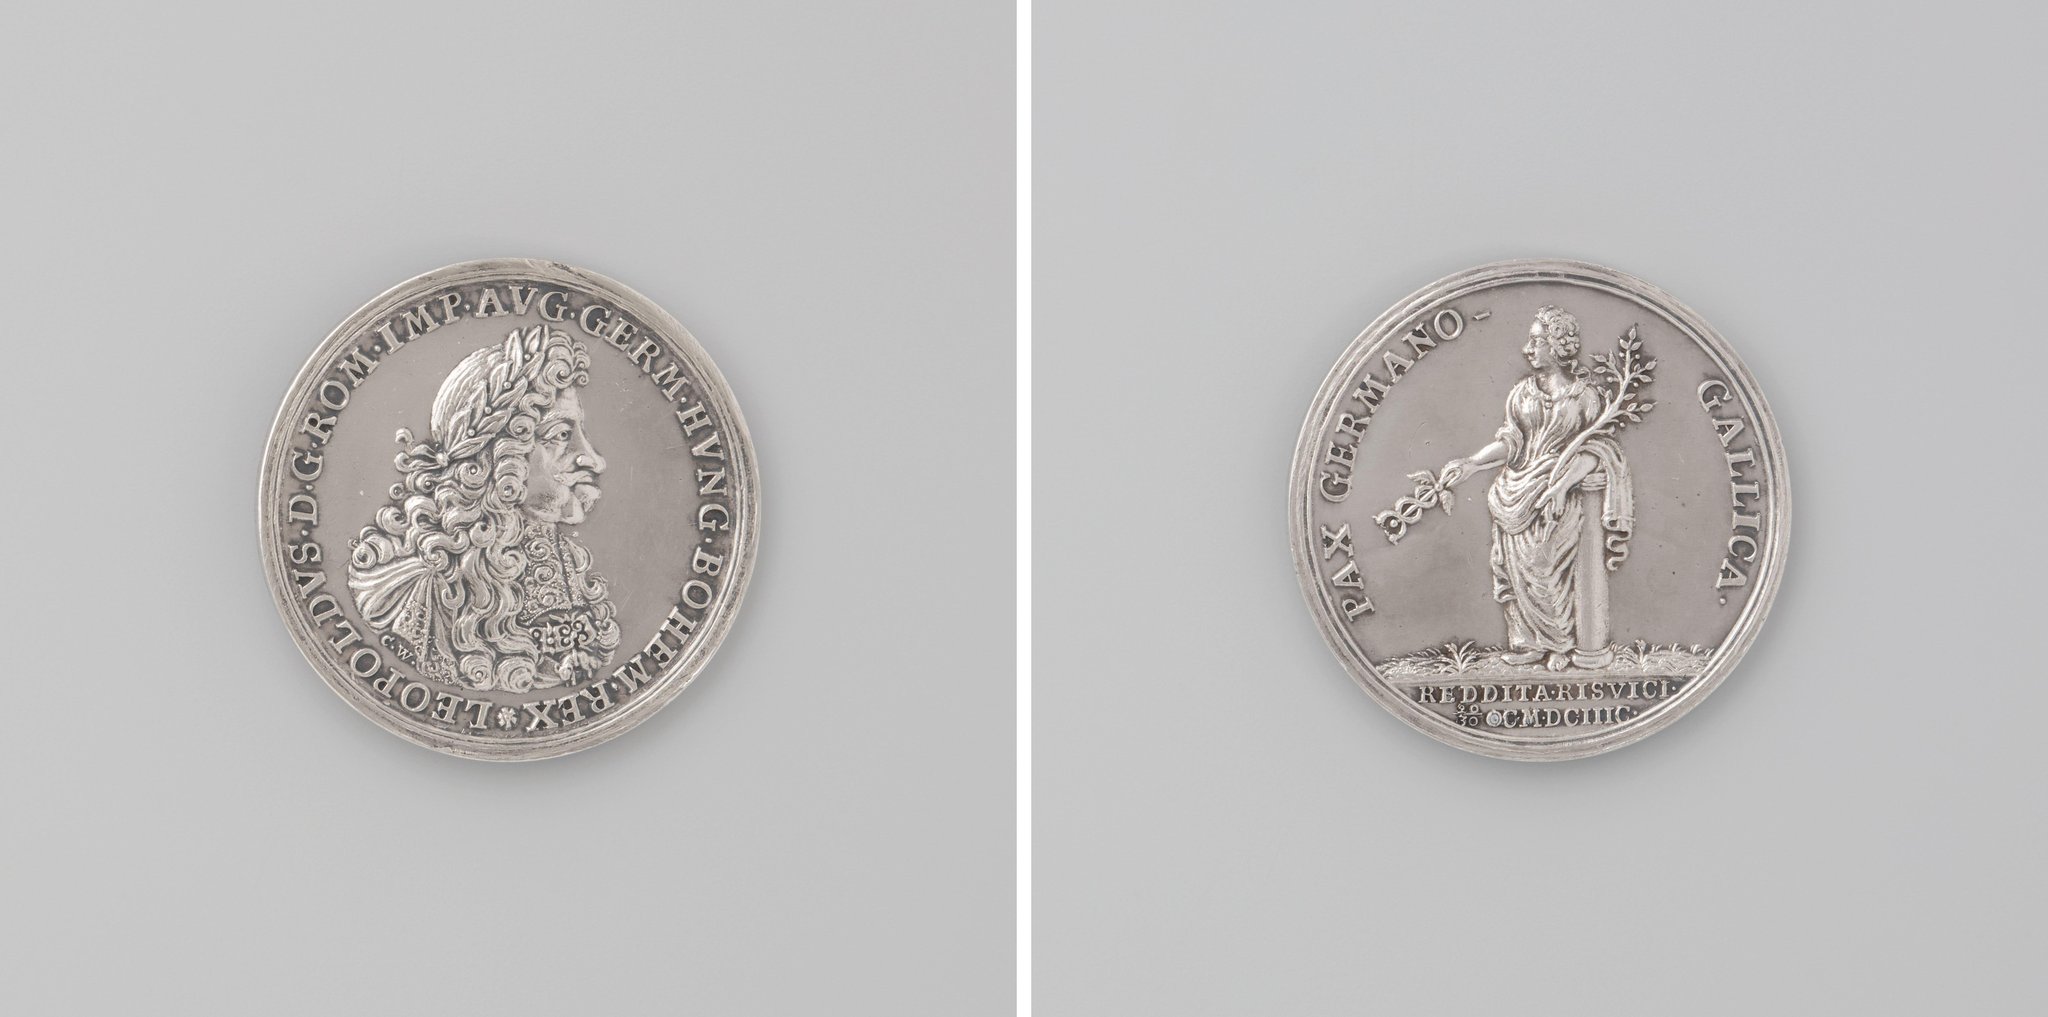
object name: history medal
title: Vrede van Rijswijk, ter ere van keizer Leopold I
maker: christian wermuth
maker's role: medailleur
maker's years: 1661-1739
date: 1697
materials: silver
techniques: striking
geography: gotha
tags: vienna, leopold i (keizer van duitsland)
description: Zilveren penning. Voorzijde: borststuk man met lauwerkrans binnen omschrift. Keerzijde: Vrede met olijftak en Mercuriusstaf leunend op pilaar binnen omschrift; afsnede: opschrift